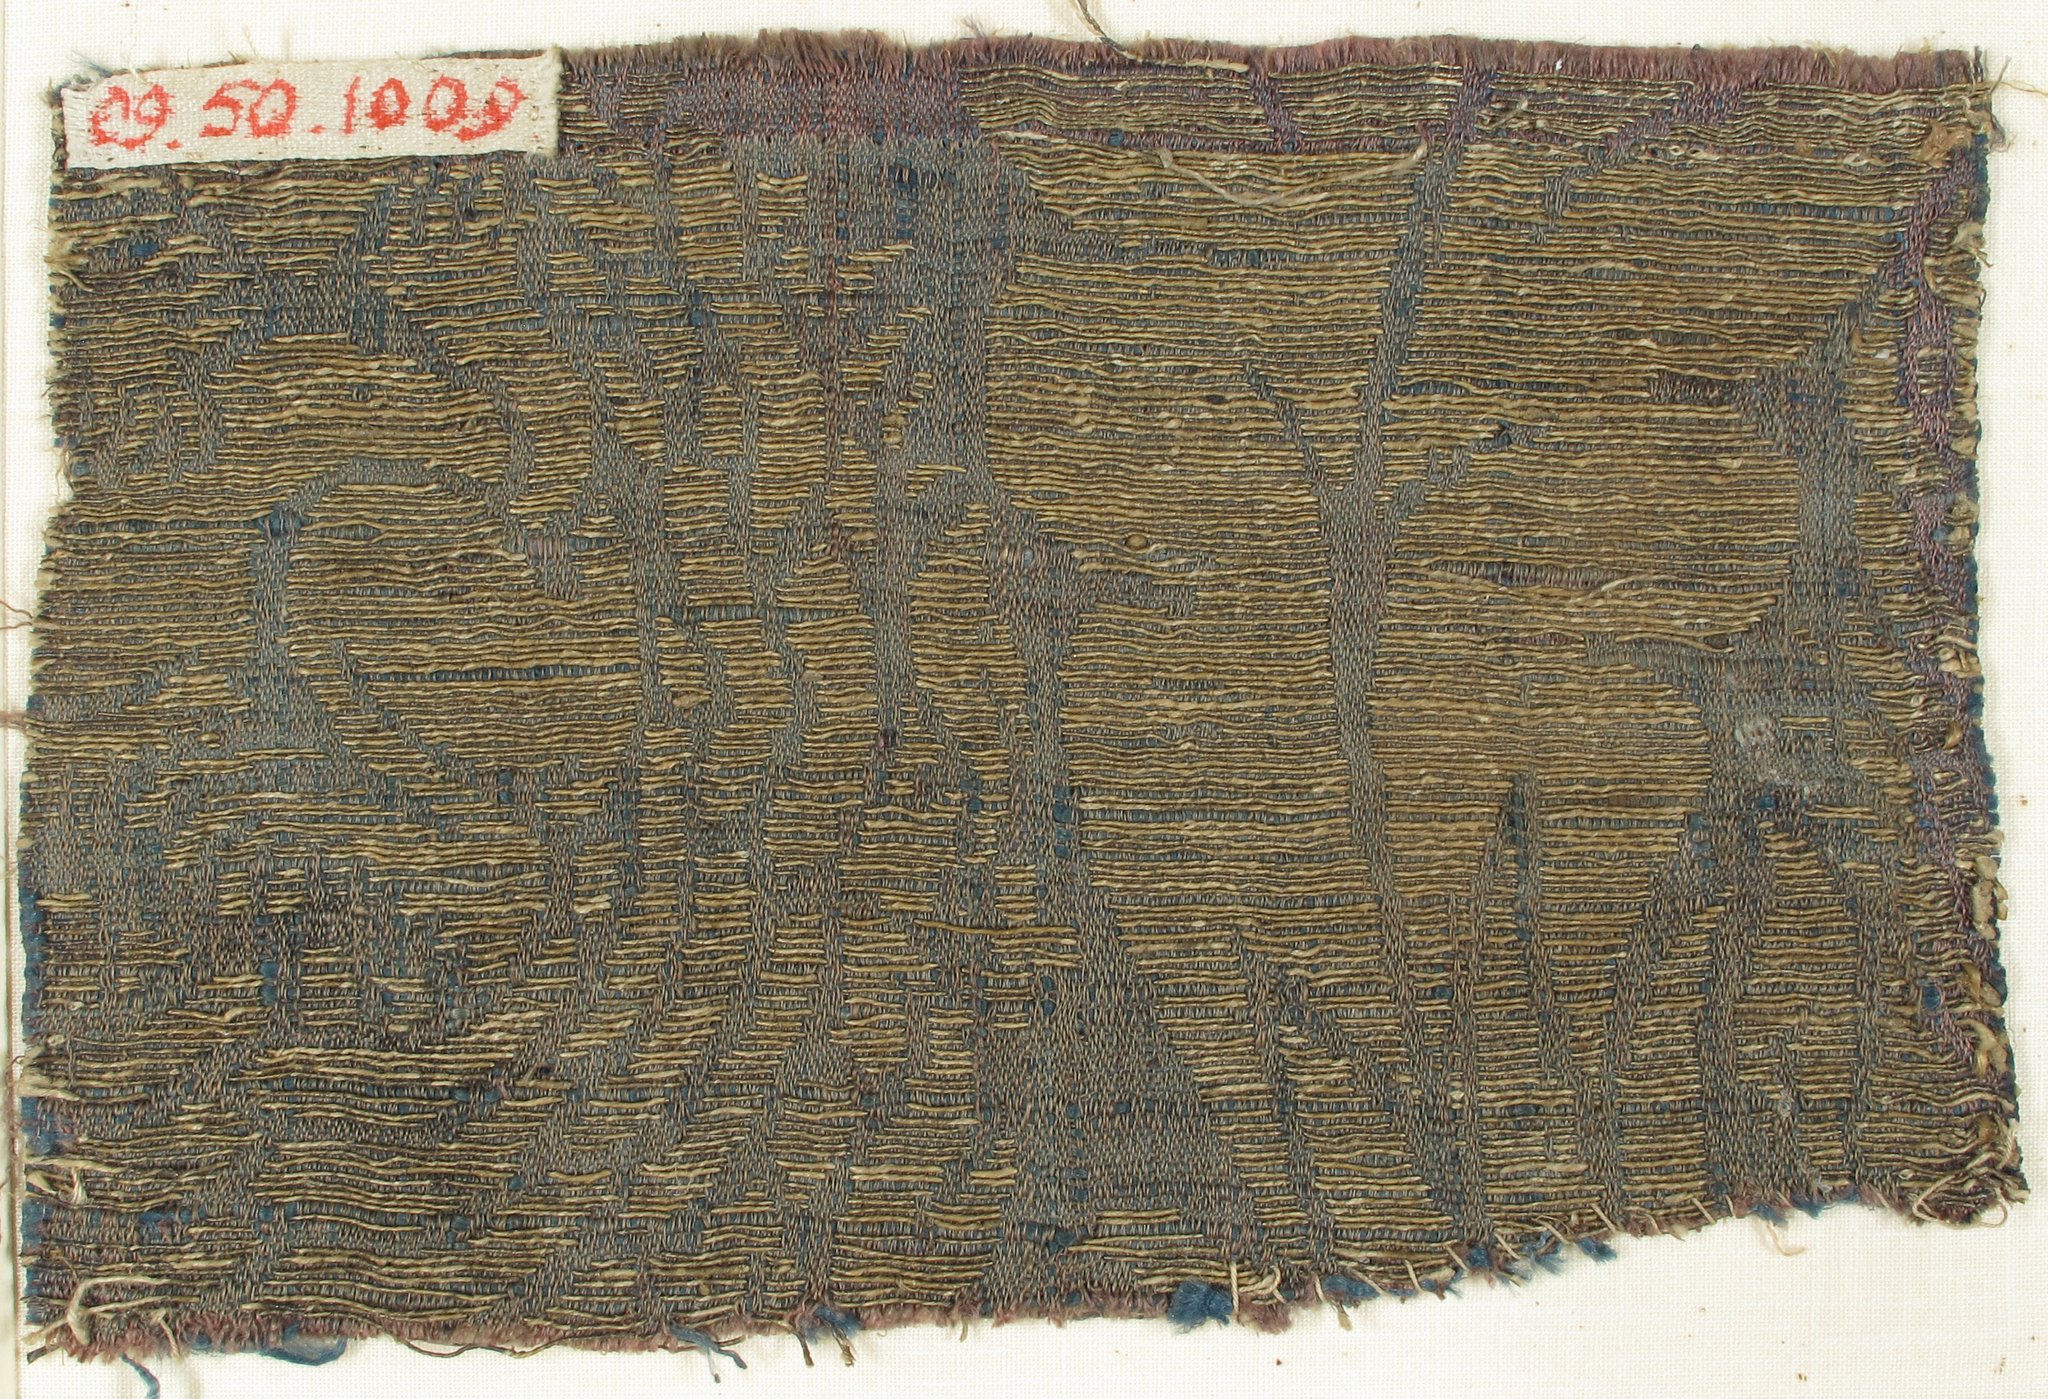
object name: textile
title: Textile with Lions and Peacocks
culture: italian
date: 1401-1500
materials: gold thread, silk